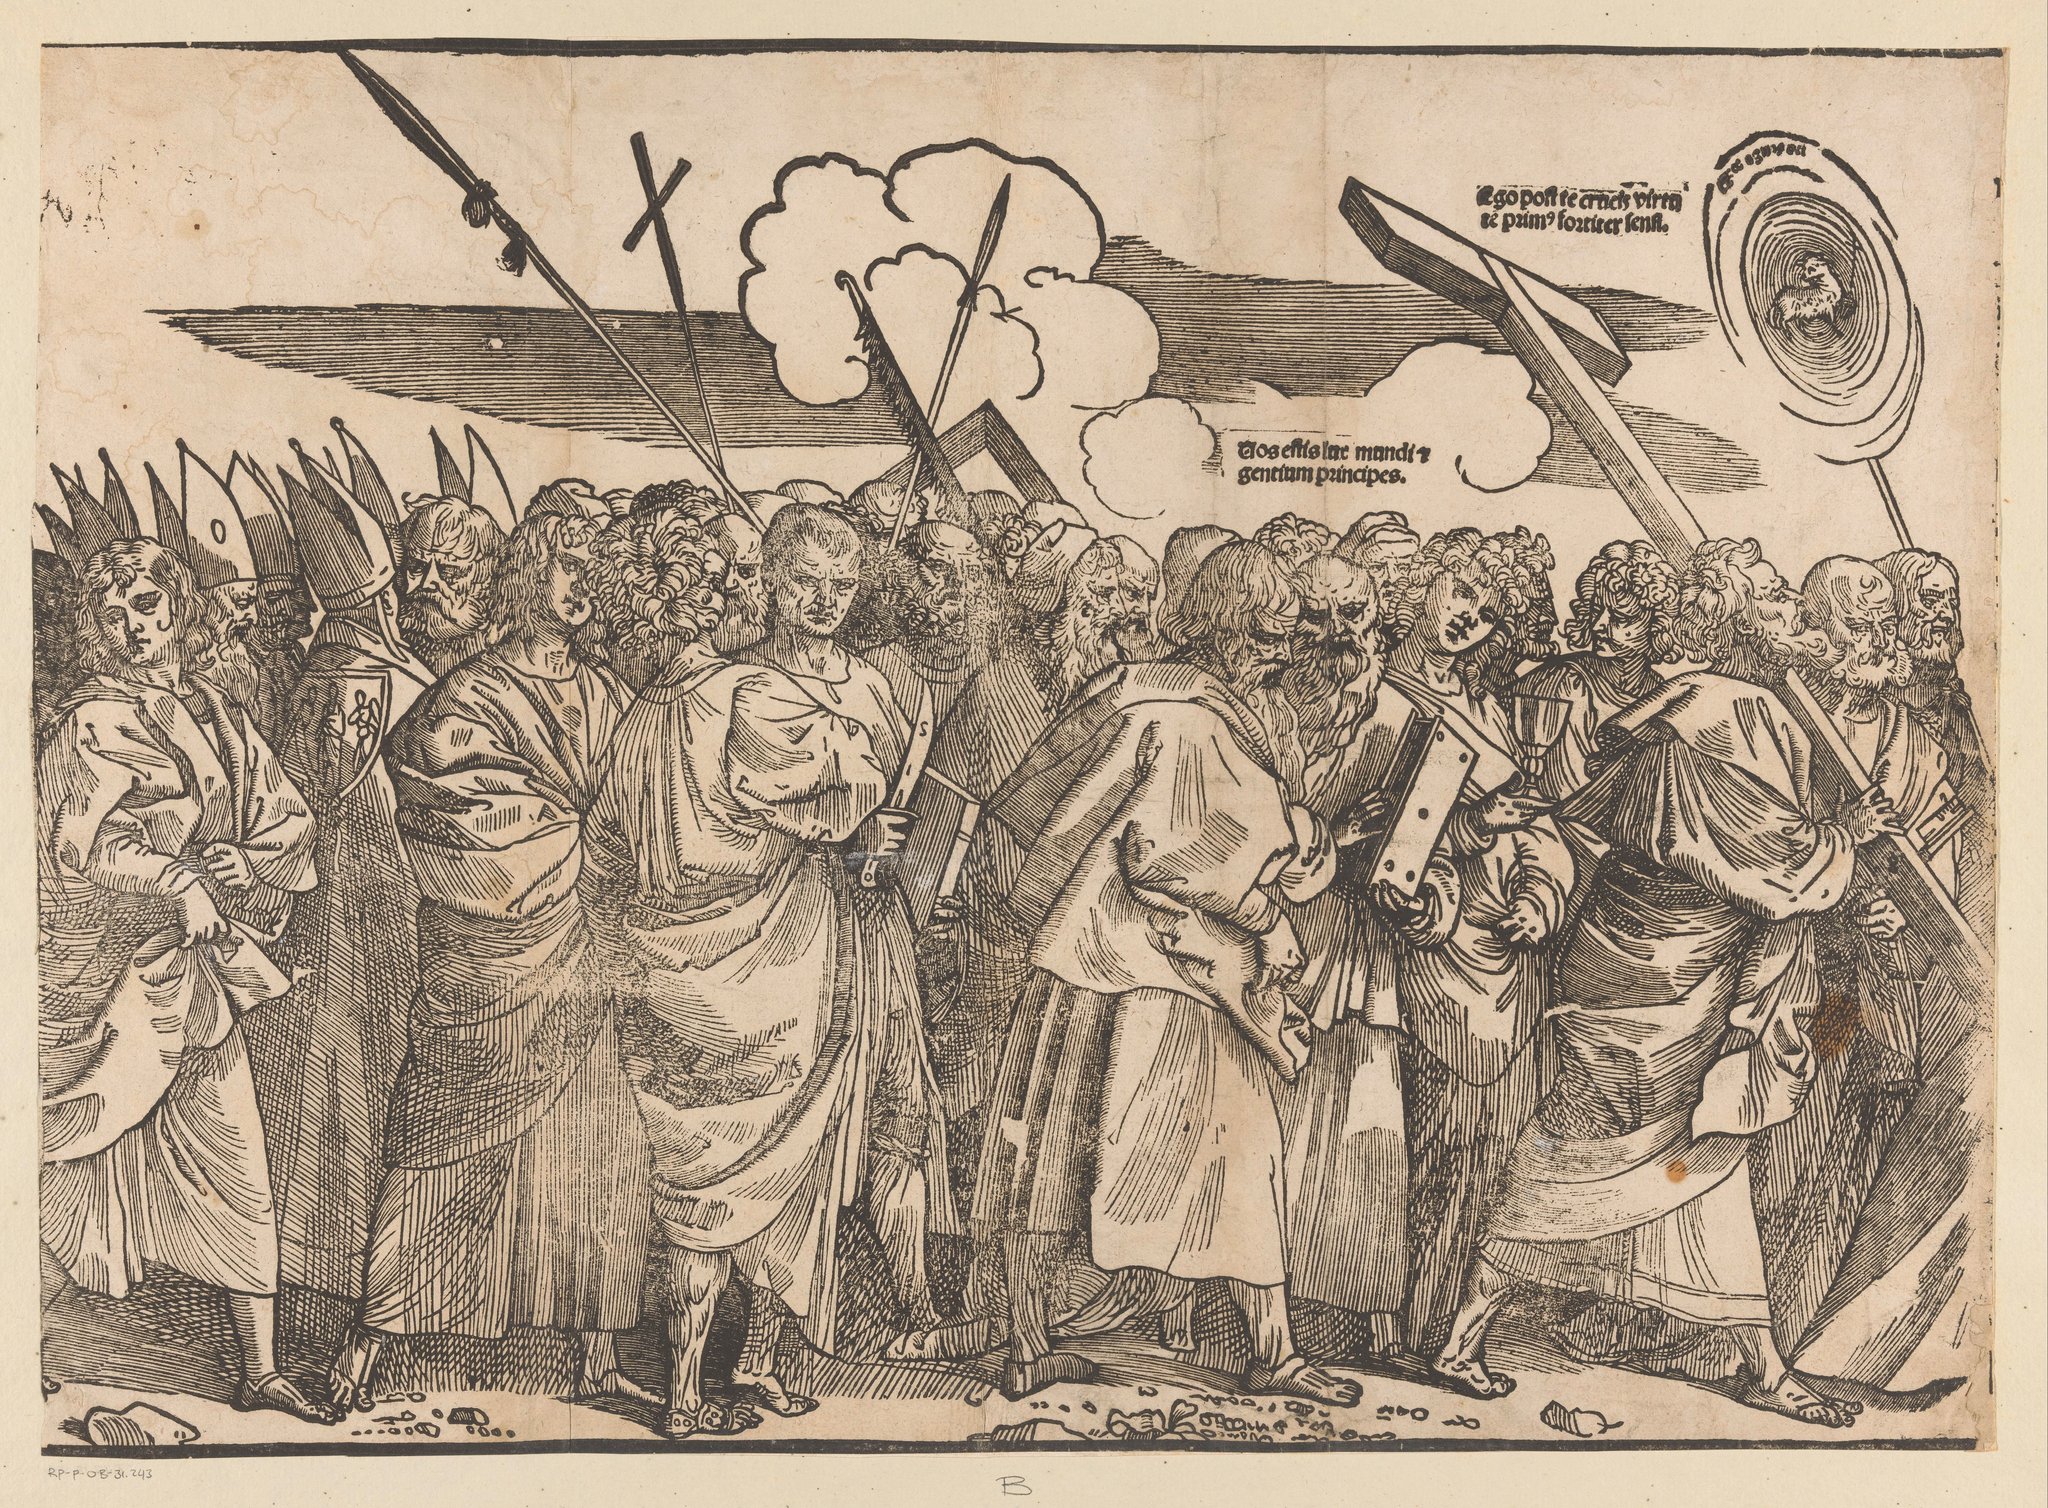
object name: print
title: Triomf van Christus (tweede deel)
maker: Anonymous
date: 1517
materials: paper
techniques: woodcut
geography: italy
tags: john the baptist; possible attributes: book, reed cross, baptismal cup, honeycomb, lamb, staff, the apostle peter, first bishop of rome; possible attributes: book, cock, (upturned) cross, (triple) crozier, fish, key, scroll, ship, tiara, specific forms of the cross: tau-cross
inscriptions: collector's mark: Lugt 240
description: Gedeelte van de Triomf van Christus met verscheidene heiligen met martelwerktuigen. Op verscheidene plaatsen tekst in het Latijn.